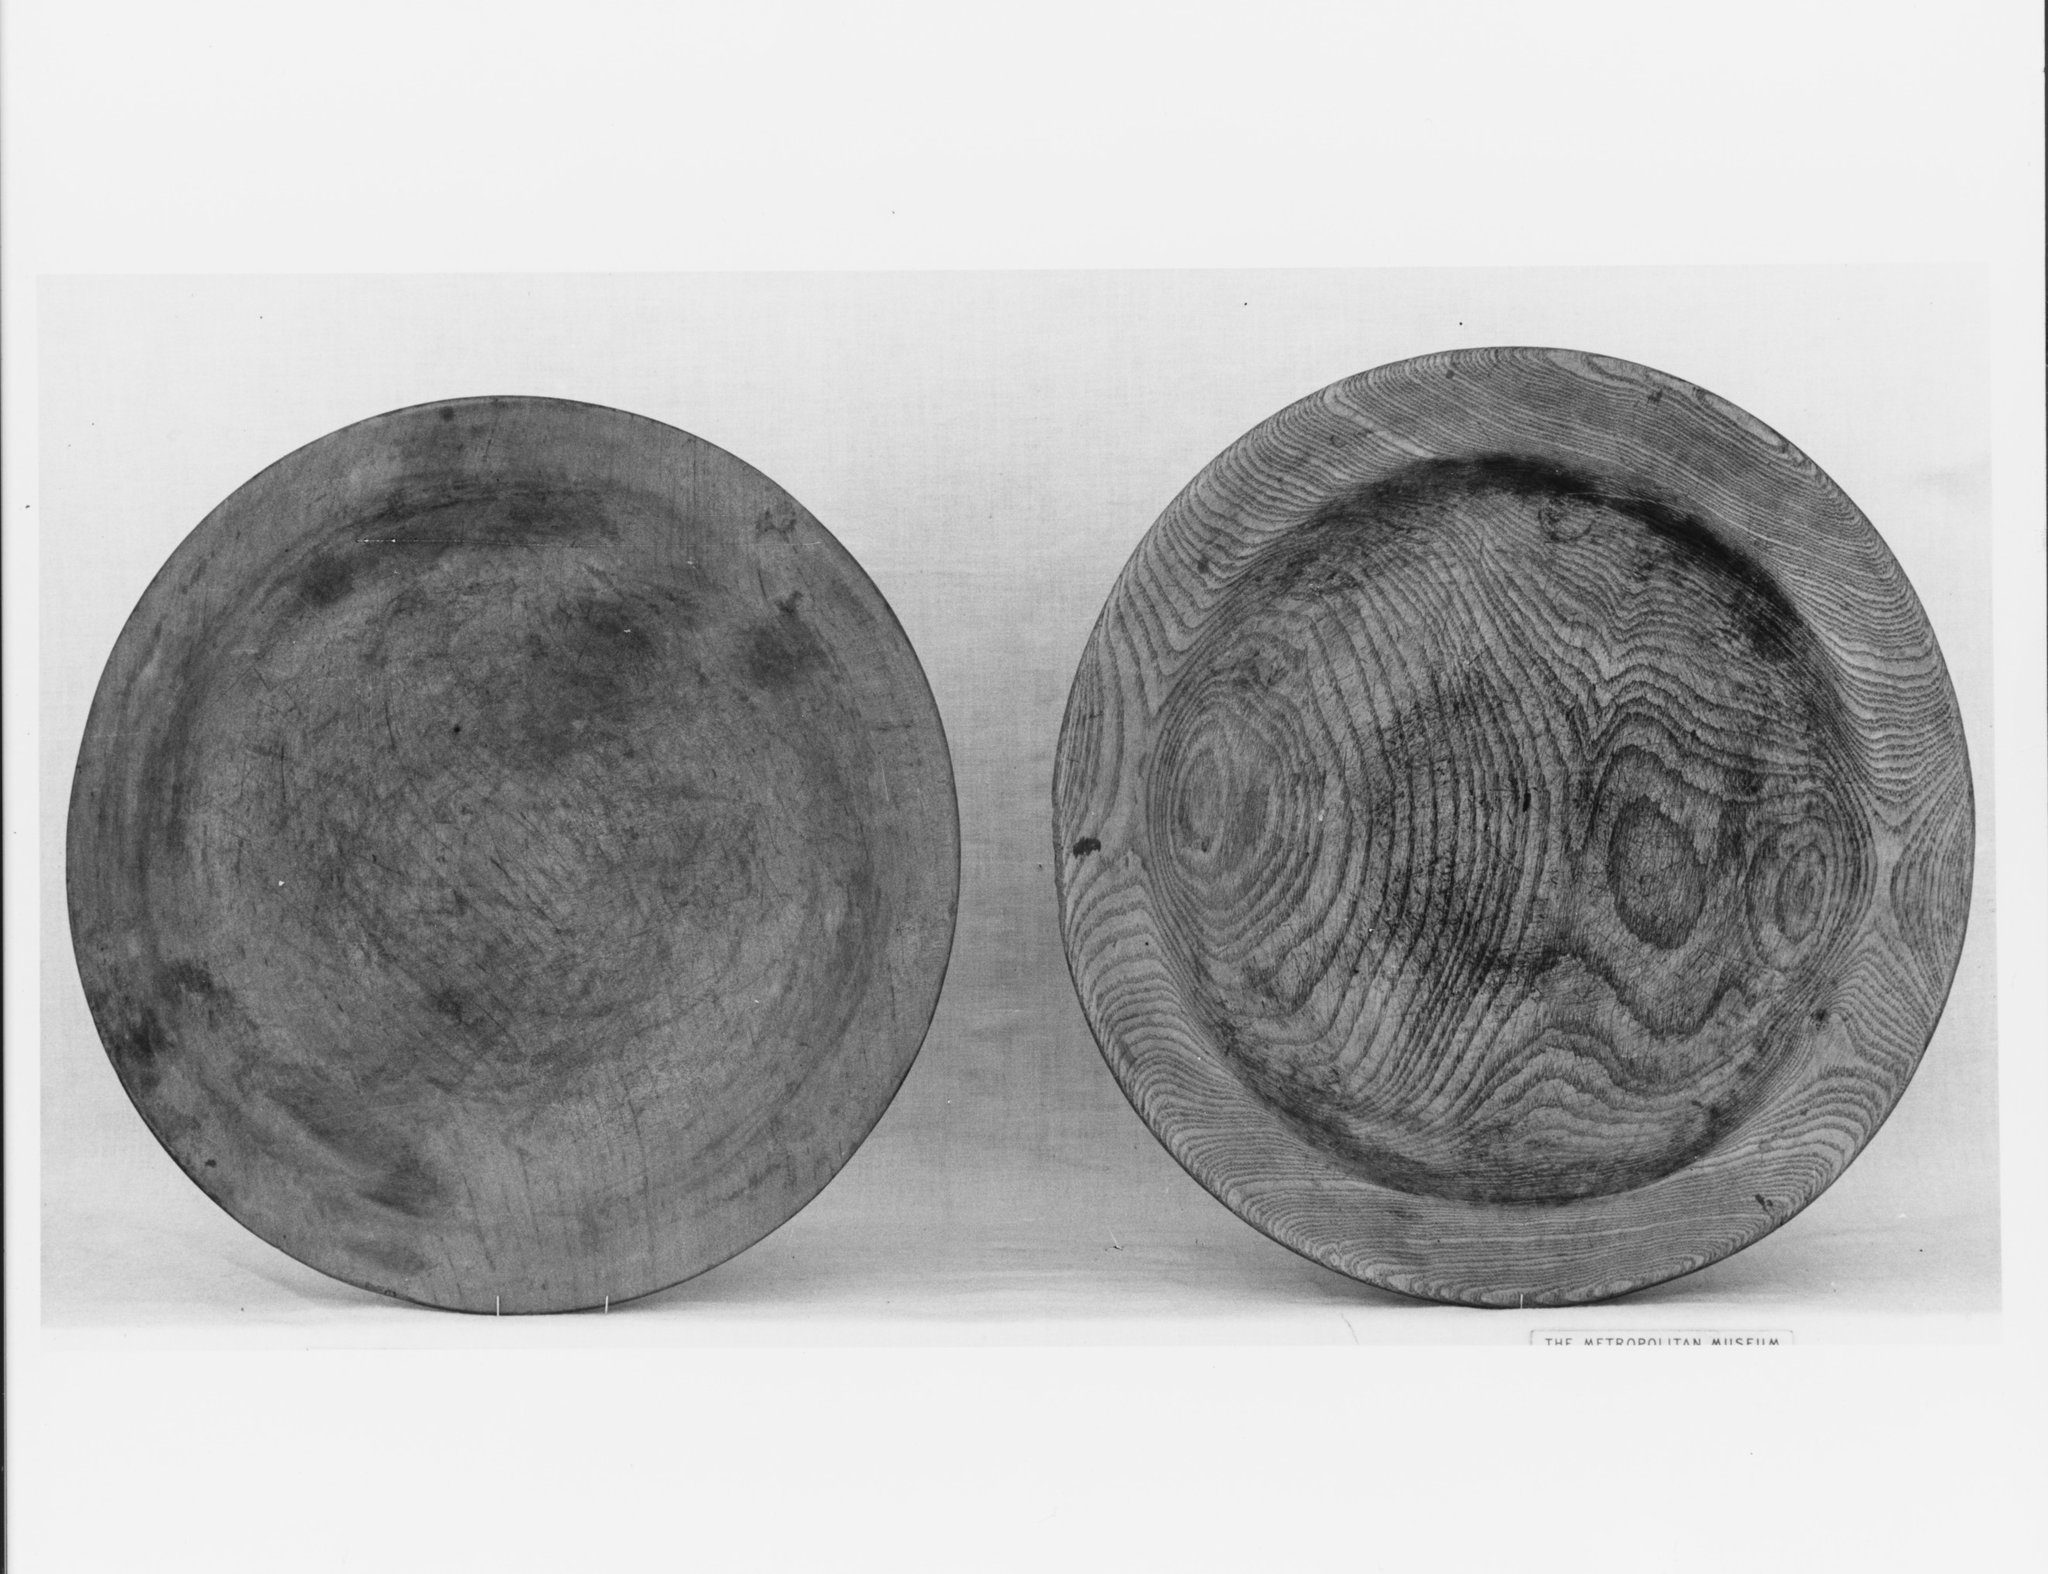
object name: plate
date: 1670-1730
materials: wood